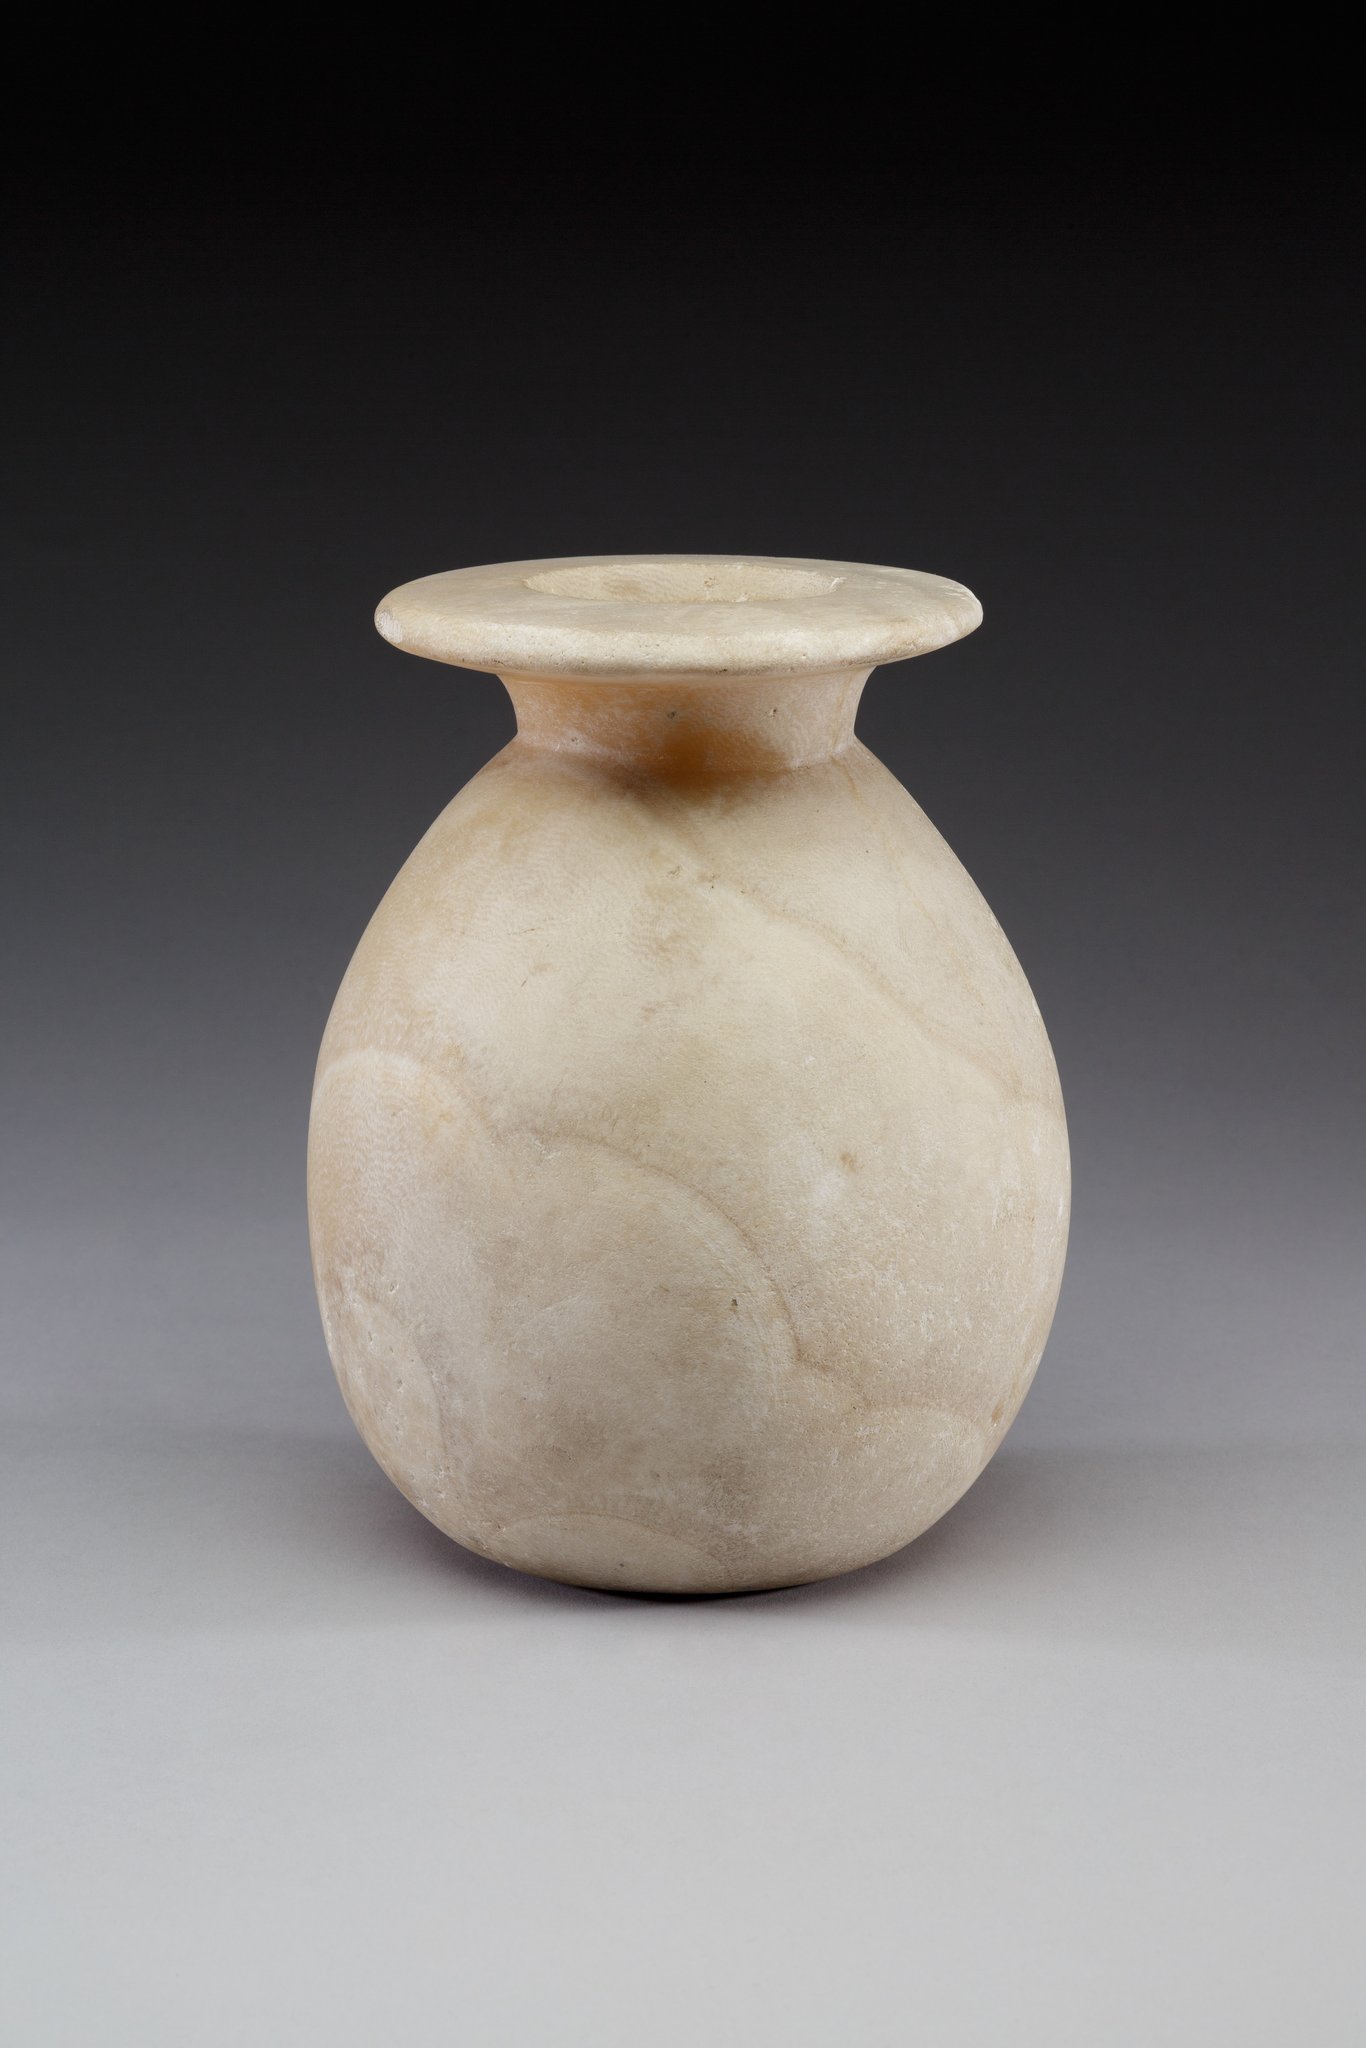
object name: jar, piriform, rennefer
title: Piriform Jar of Rennefer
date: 1504-1447 BCE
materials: stone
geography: egypt